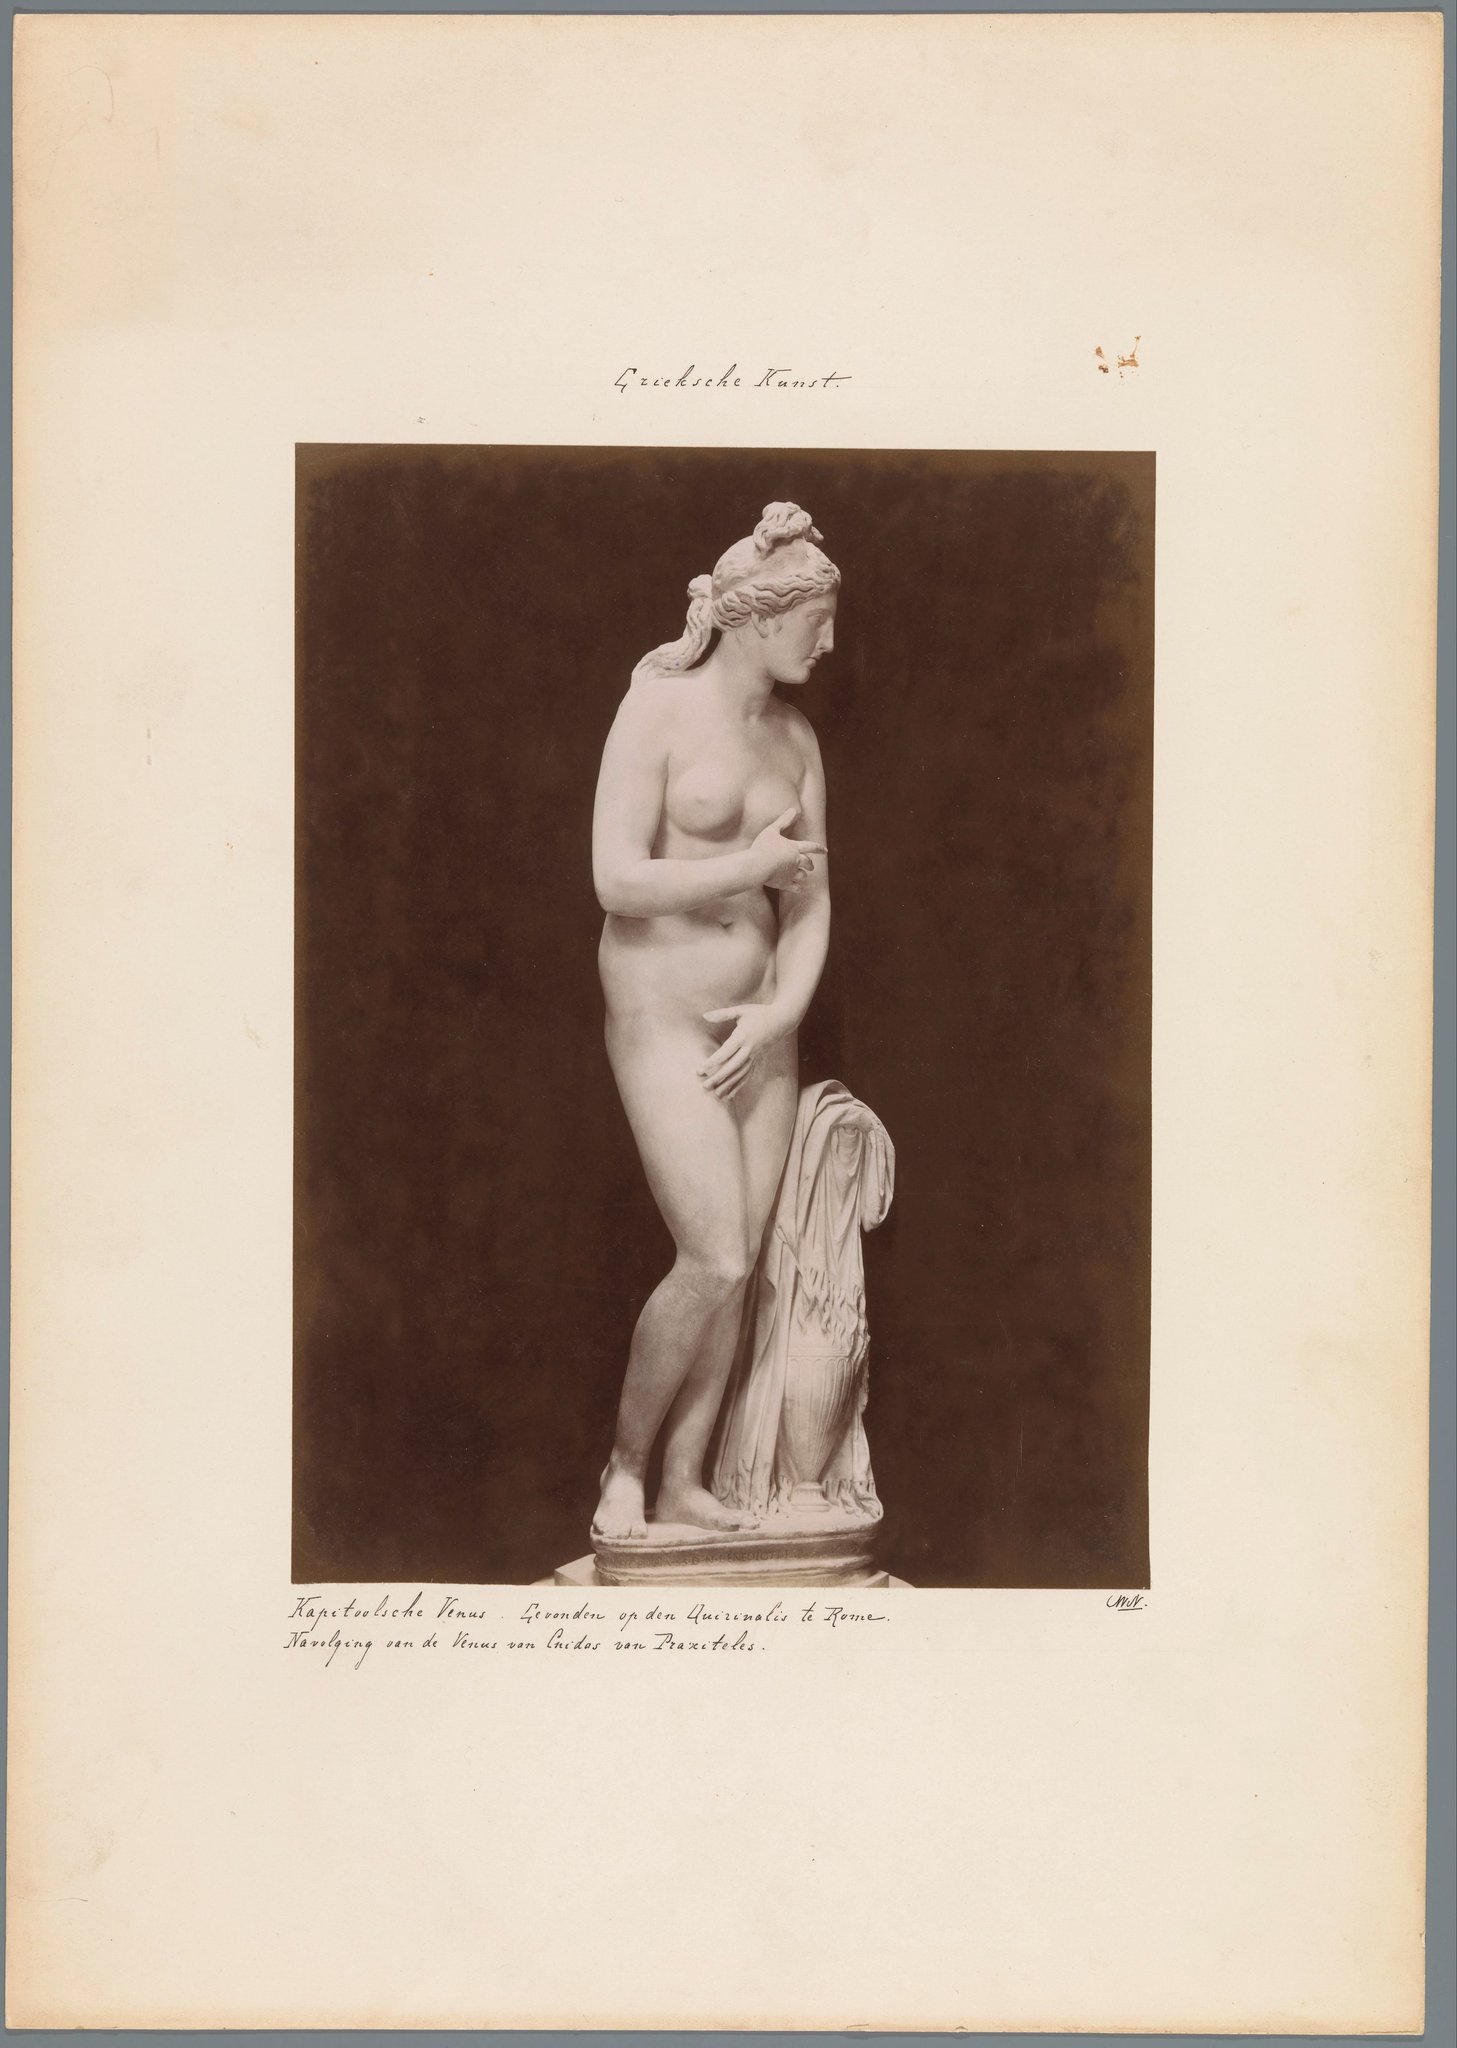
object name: photograph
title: Capitolijnse Venus in de Capitolijnse Musea te Rome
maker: Anonymous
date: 1875-1900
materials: cardboard, photographic support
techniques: albumen print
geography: capitolijnse musea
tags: woman (showing herself) undressed, quasi-nude, (story of) venus (aphrodite), sculpture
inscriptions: inscription: ‘Grieksche Kunst. Kapitoolsche Venus. (...) Navolging van de Venus van Cnidos van Praxiteles.’, inscription: ‘CWN.’, collector's mark: ‘KUNSTNIJVERHEIDSCHOOL QUELLINUS AMSTERDAM FRANS HALSSTRAAT 14.’, collector's mark: ‘INSTITUUT VOOR KUNST- NIJVERHEIDSONDERWIJS GABRIËL METSUSTRAAT No. 16. AMSTERDAM’